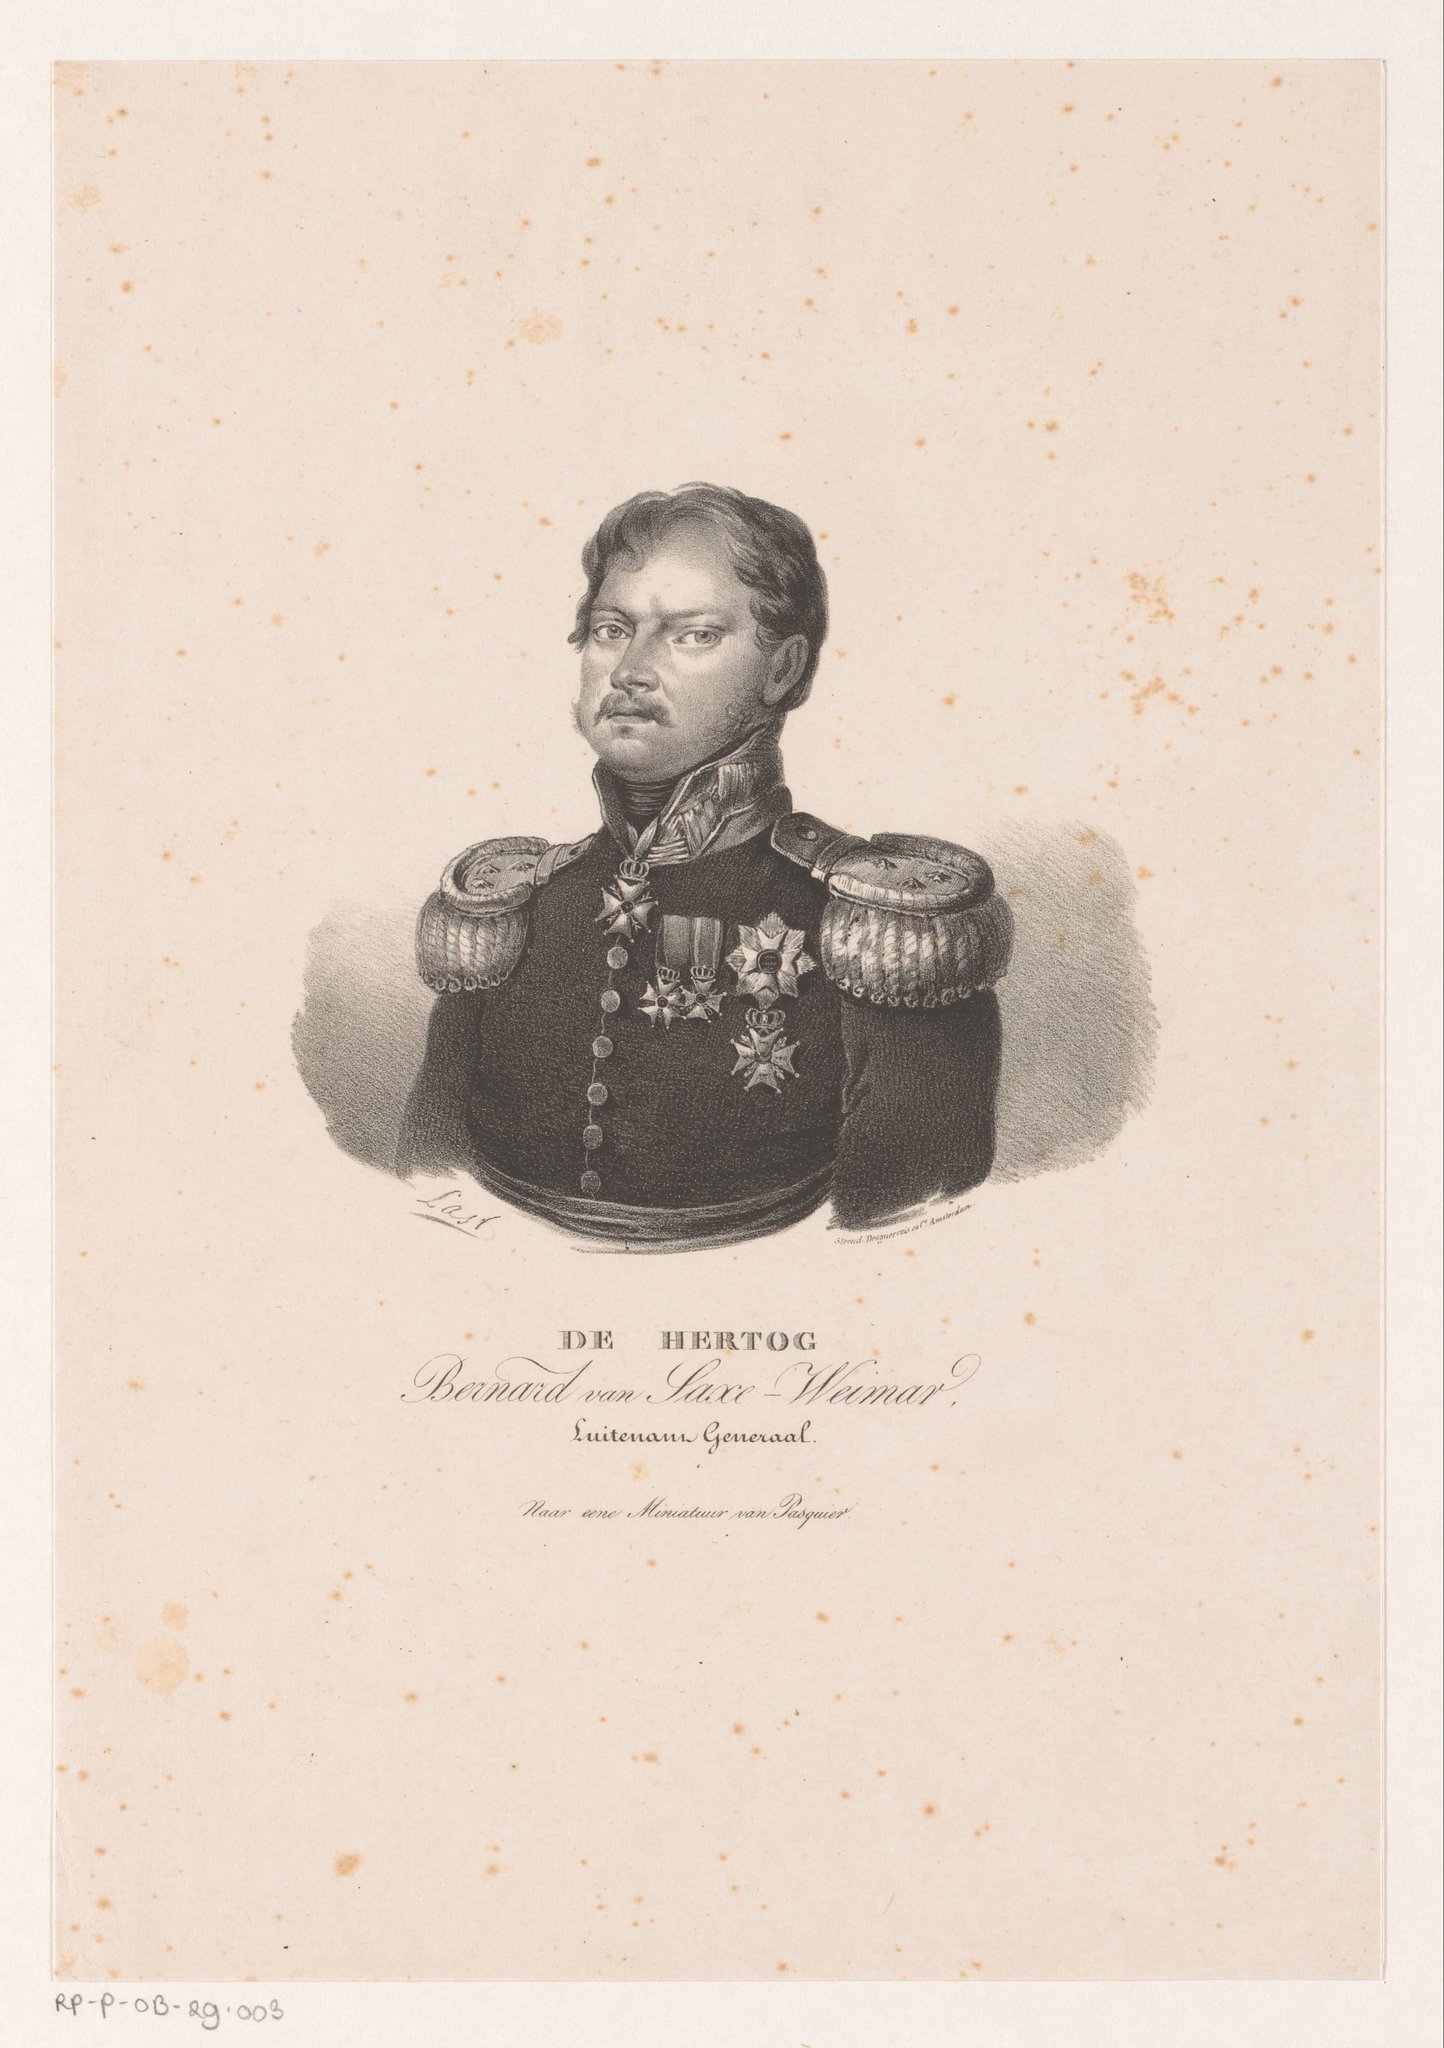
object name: print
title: De hertog Bernard van Saxe-Weimar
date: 1818-1876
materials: paper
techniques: lithograph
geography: netherlands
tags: karel bernhard (hertog van saksen-weimar-eisenach), knighthood order, historical persons (+ (full) bust portrait)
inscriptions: collector's mark: Lugt 2228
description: De geportretteerde draagt een militair kostuum met epauletten met drie sterren en ridderorden.